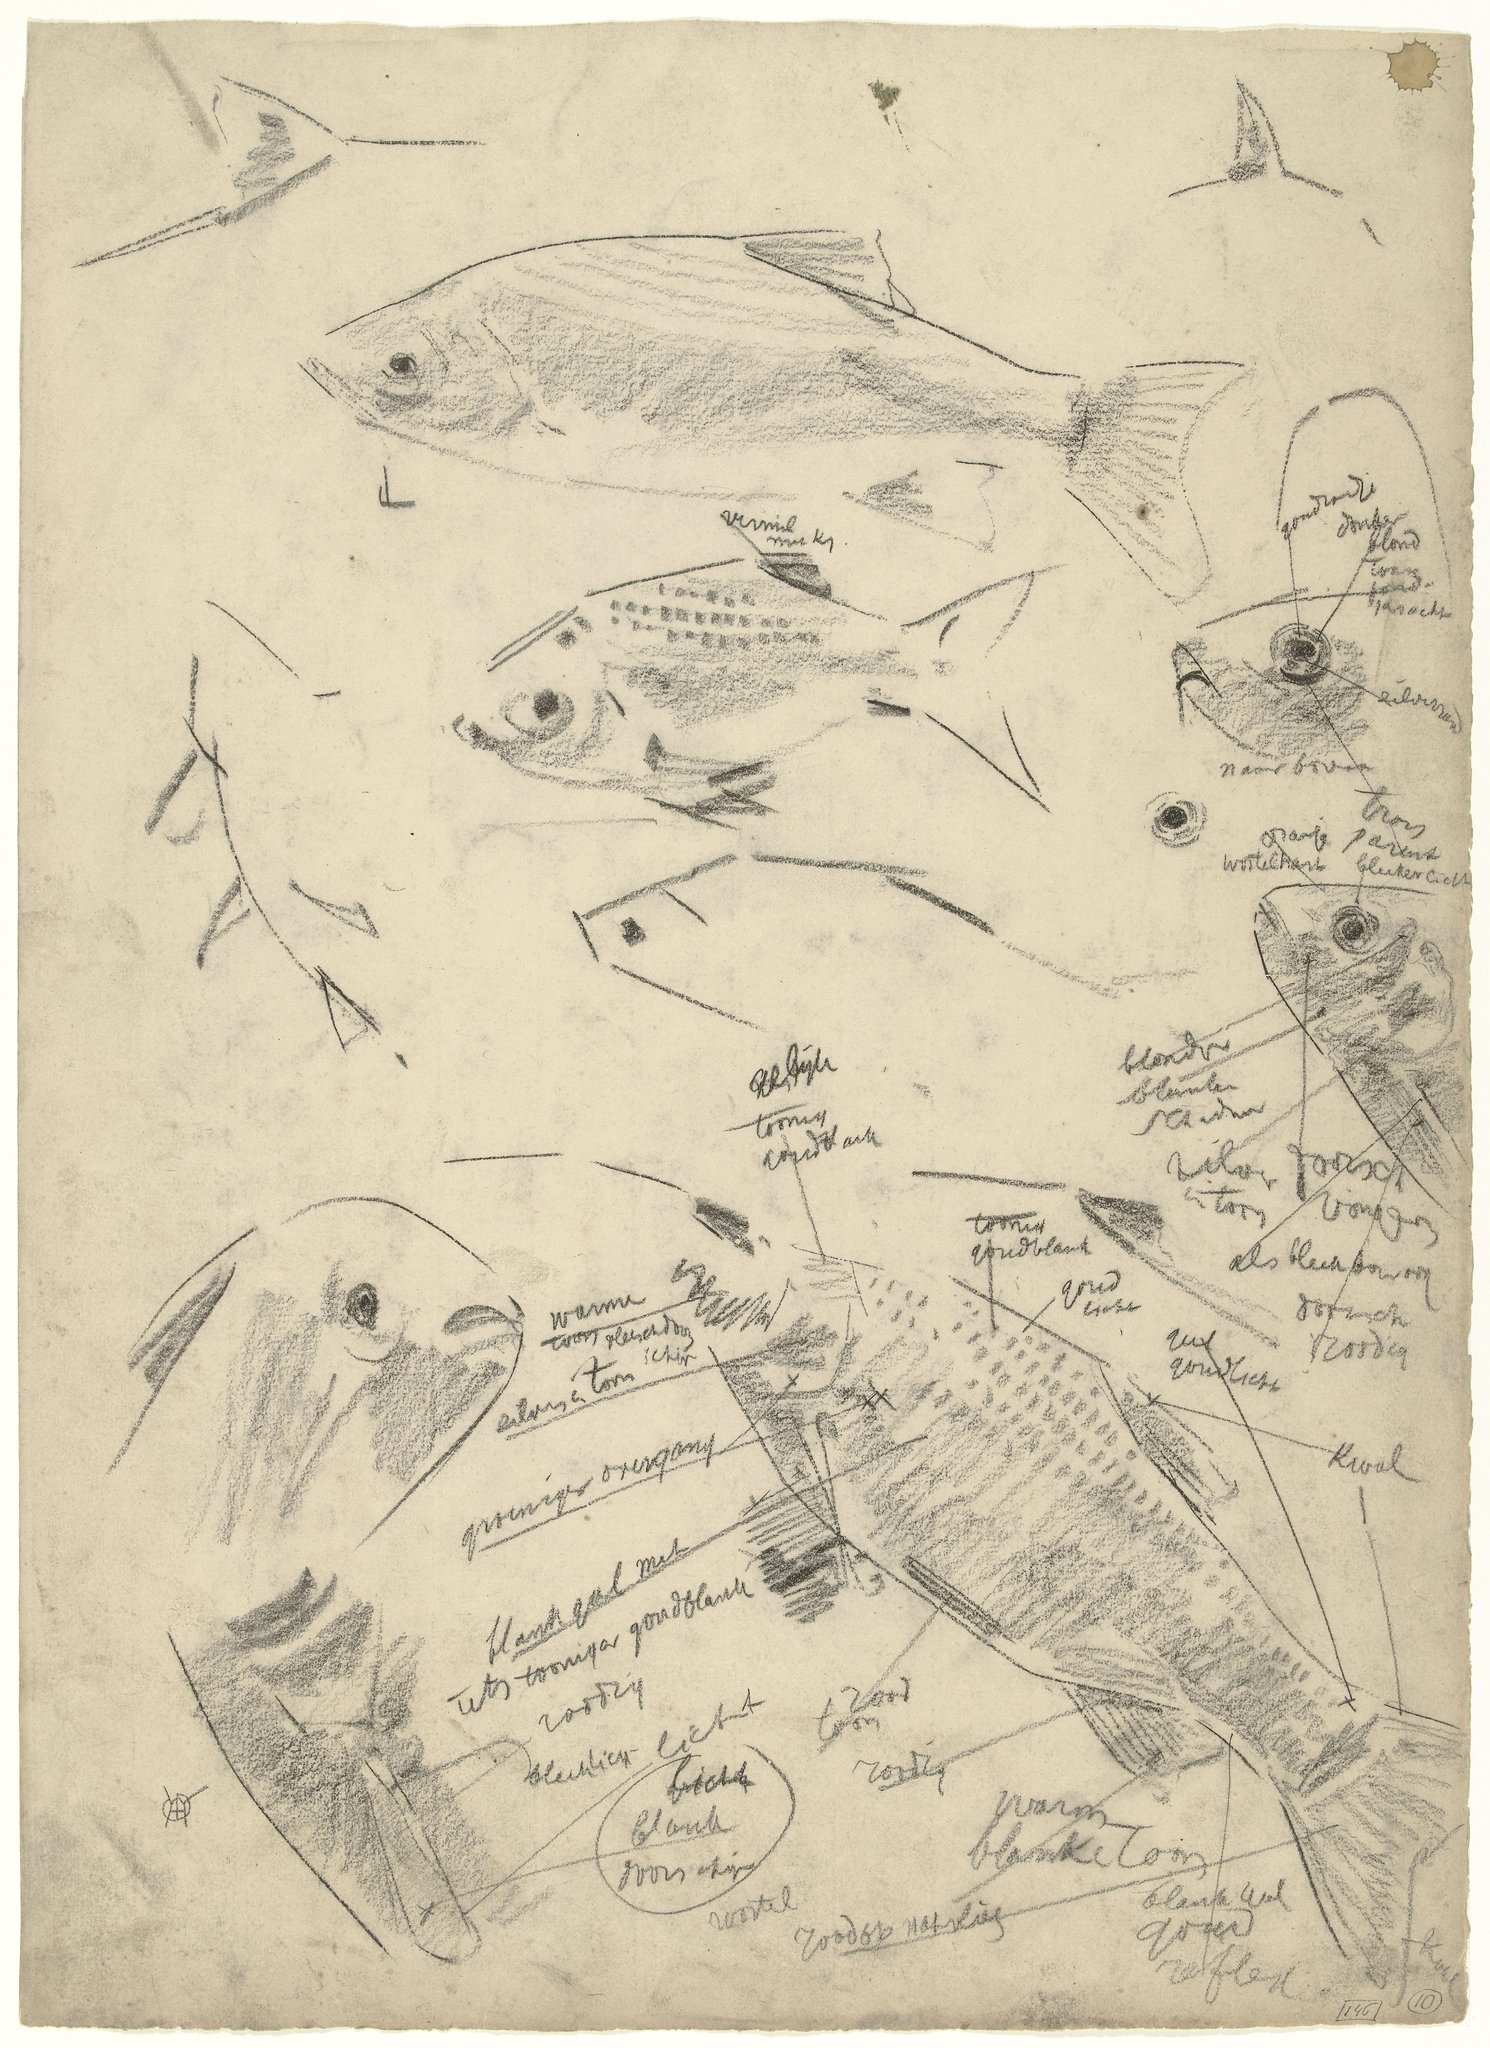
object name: drawing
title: Studies van voorns, met uitgebreide kleurnotities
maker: gerrit willem dijsselhof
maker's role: designer, draughtsman, print maker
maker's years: 1866-1924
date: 1876-1924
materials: chalk, paper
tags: bony fishes: rock bass